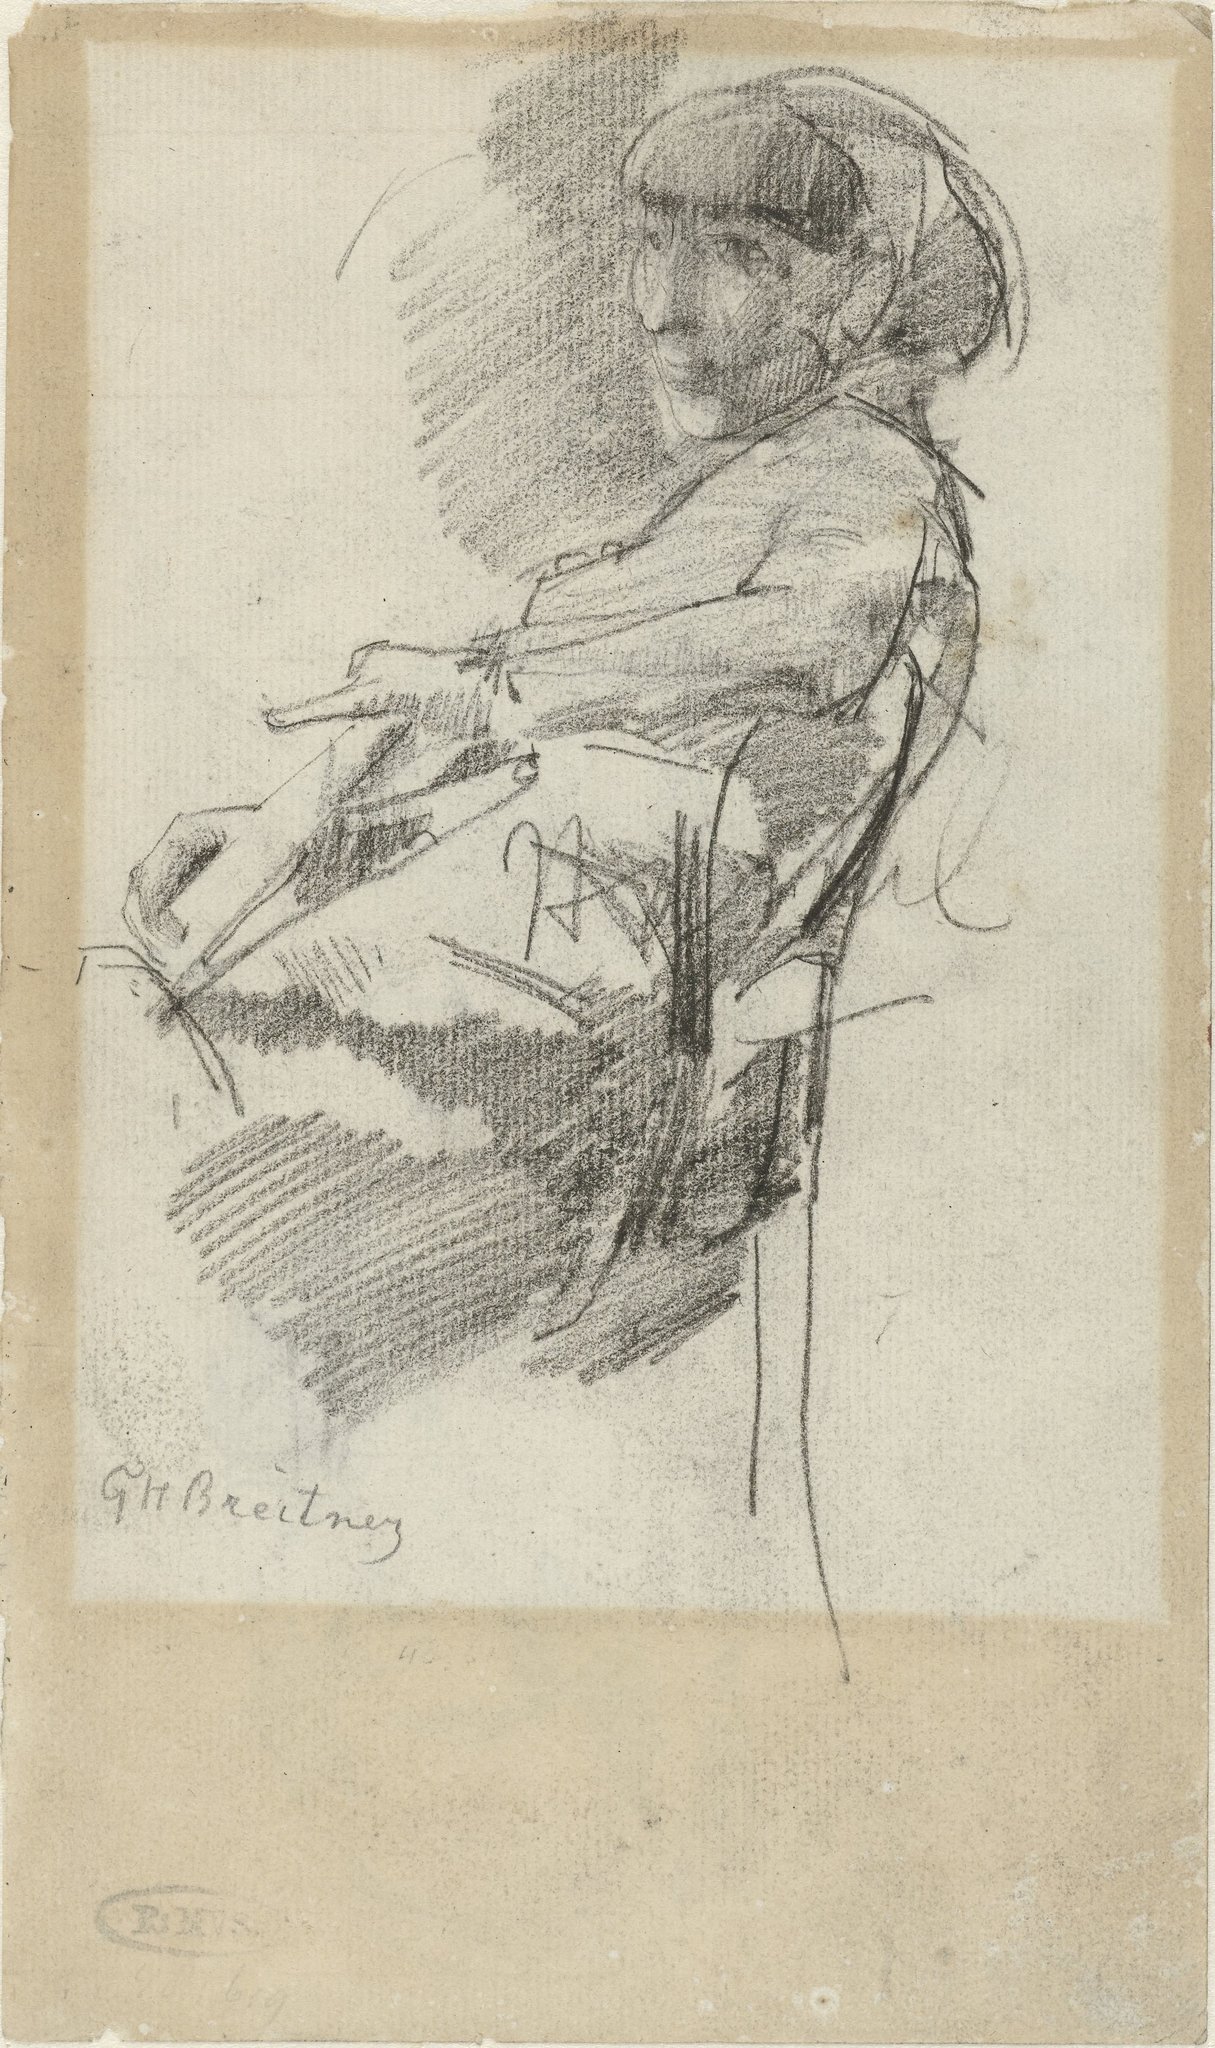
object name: drawing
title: Schets van een zittende vrouw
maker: george hendrik breitner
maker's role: draughtsman, painter, print maker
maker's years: 1857-1923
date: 1867-1923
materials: chalk, paper